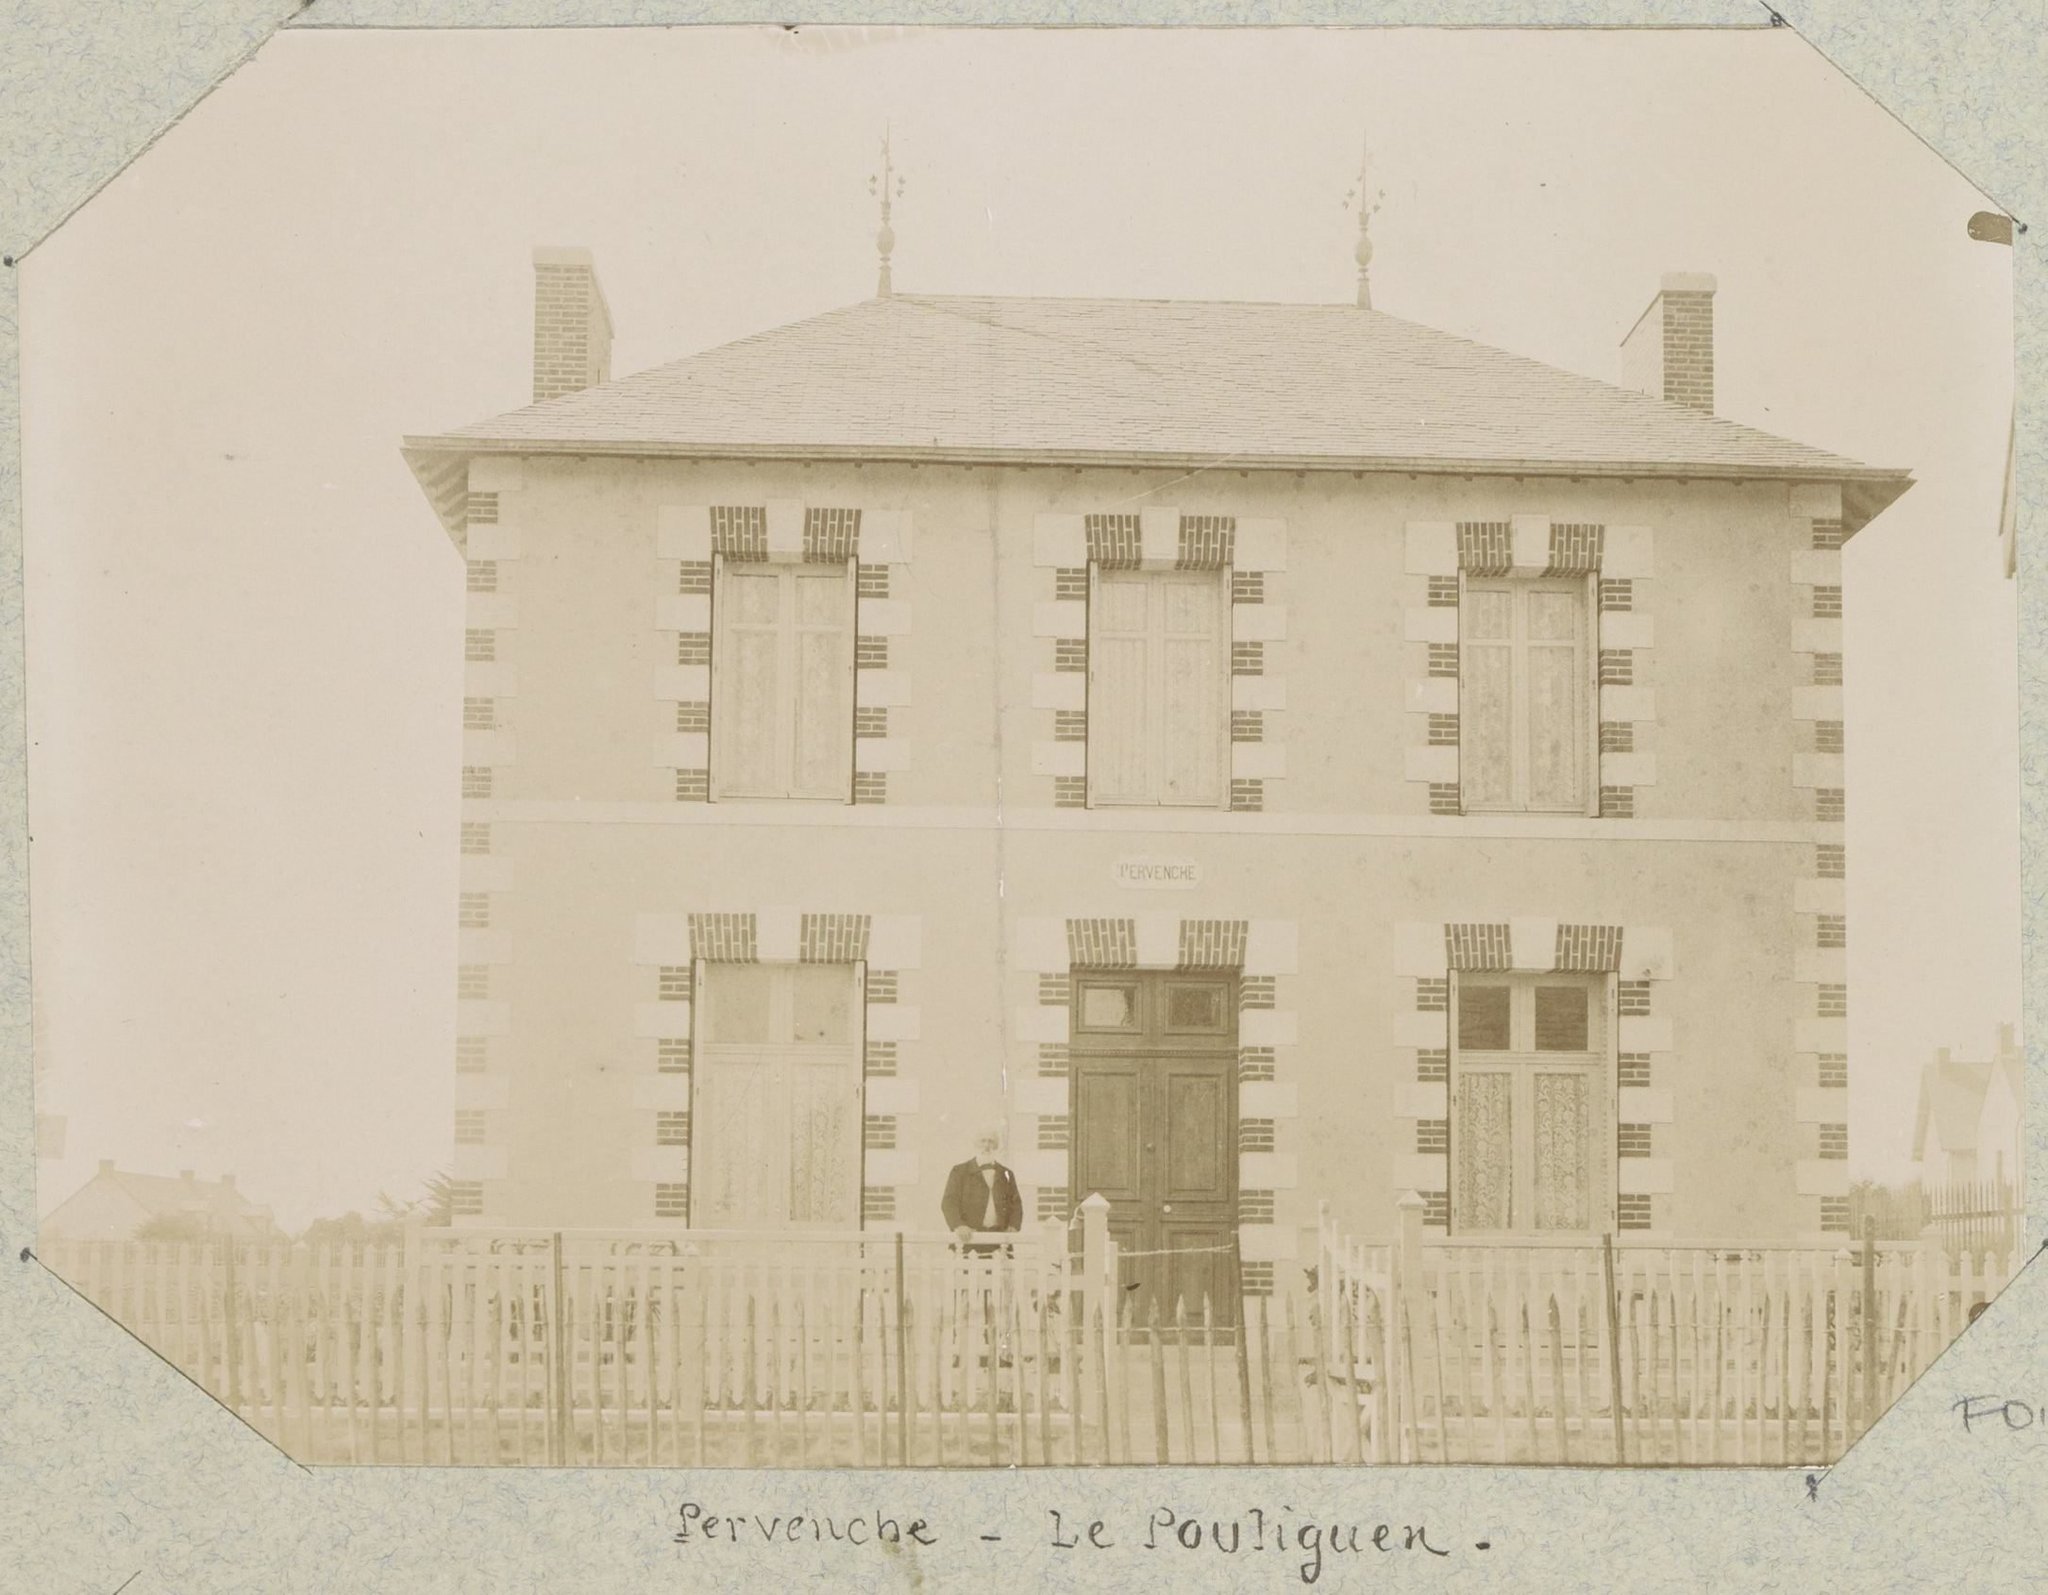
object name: photograph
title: Man staand voor een huis genaamd 'Pervenche' in Le Pouliguen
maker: Anonymous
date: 1890-1900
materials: paper, photographic support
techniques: collodion silver print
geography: le pouliguen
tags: rural housing, e.g. country-house, villa, cottage, façade (of house or building)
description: Onderdeel van Album van een Franse amateur met foto's van Frankrijk, Algerije, Palmyra, de Wereldtentoonstelling van 1900 en van bekende Fransen.